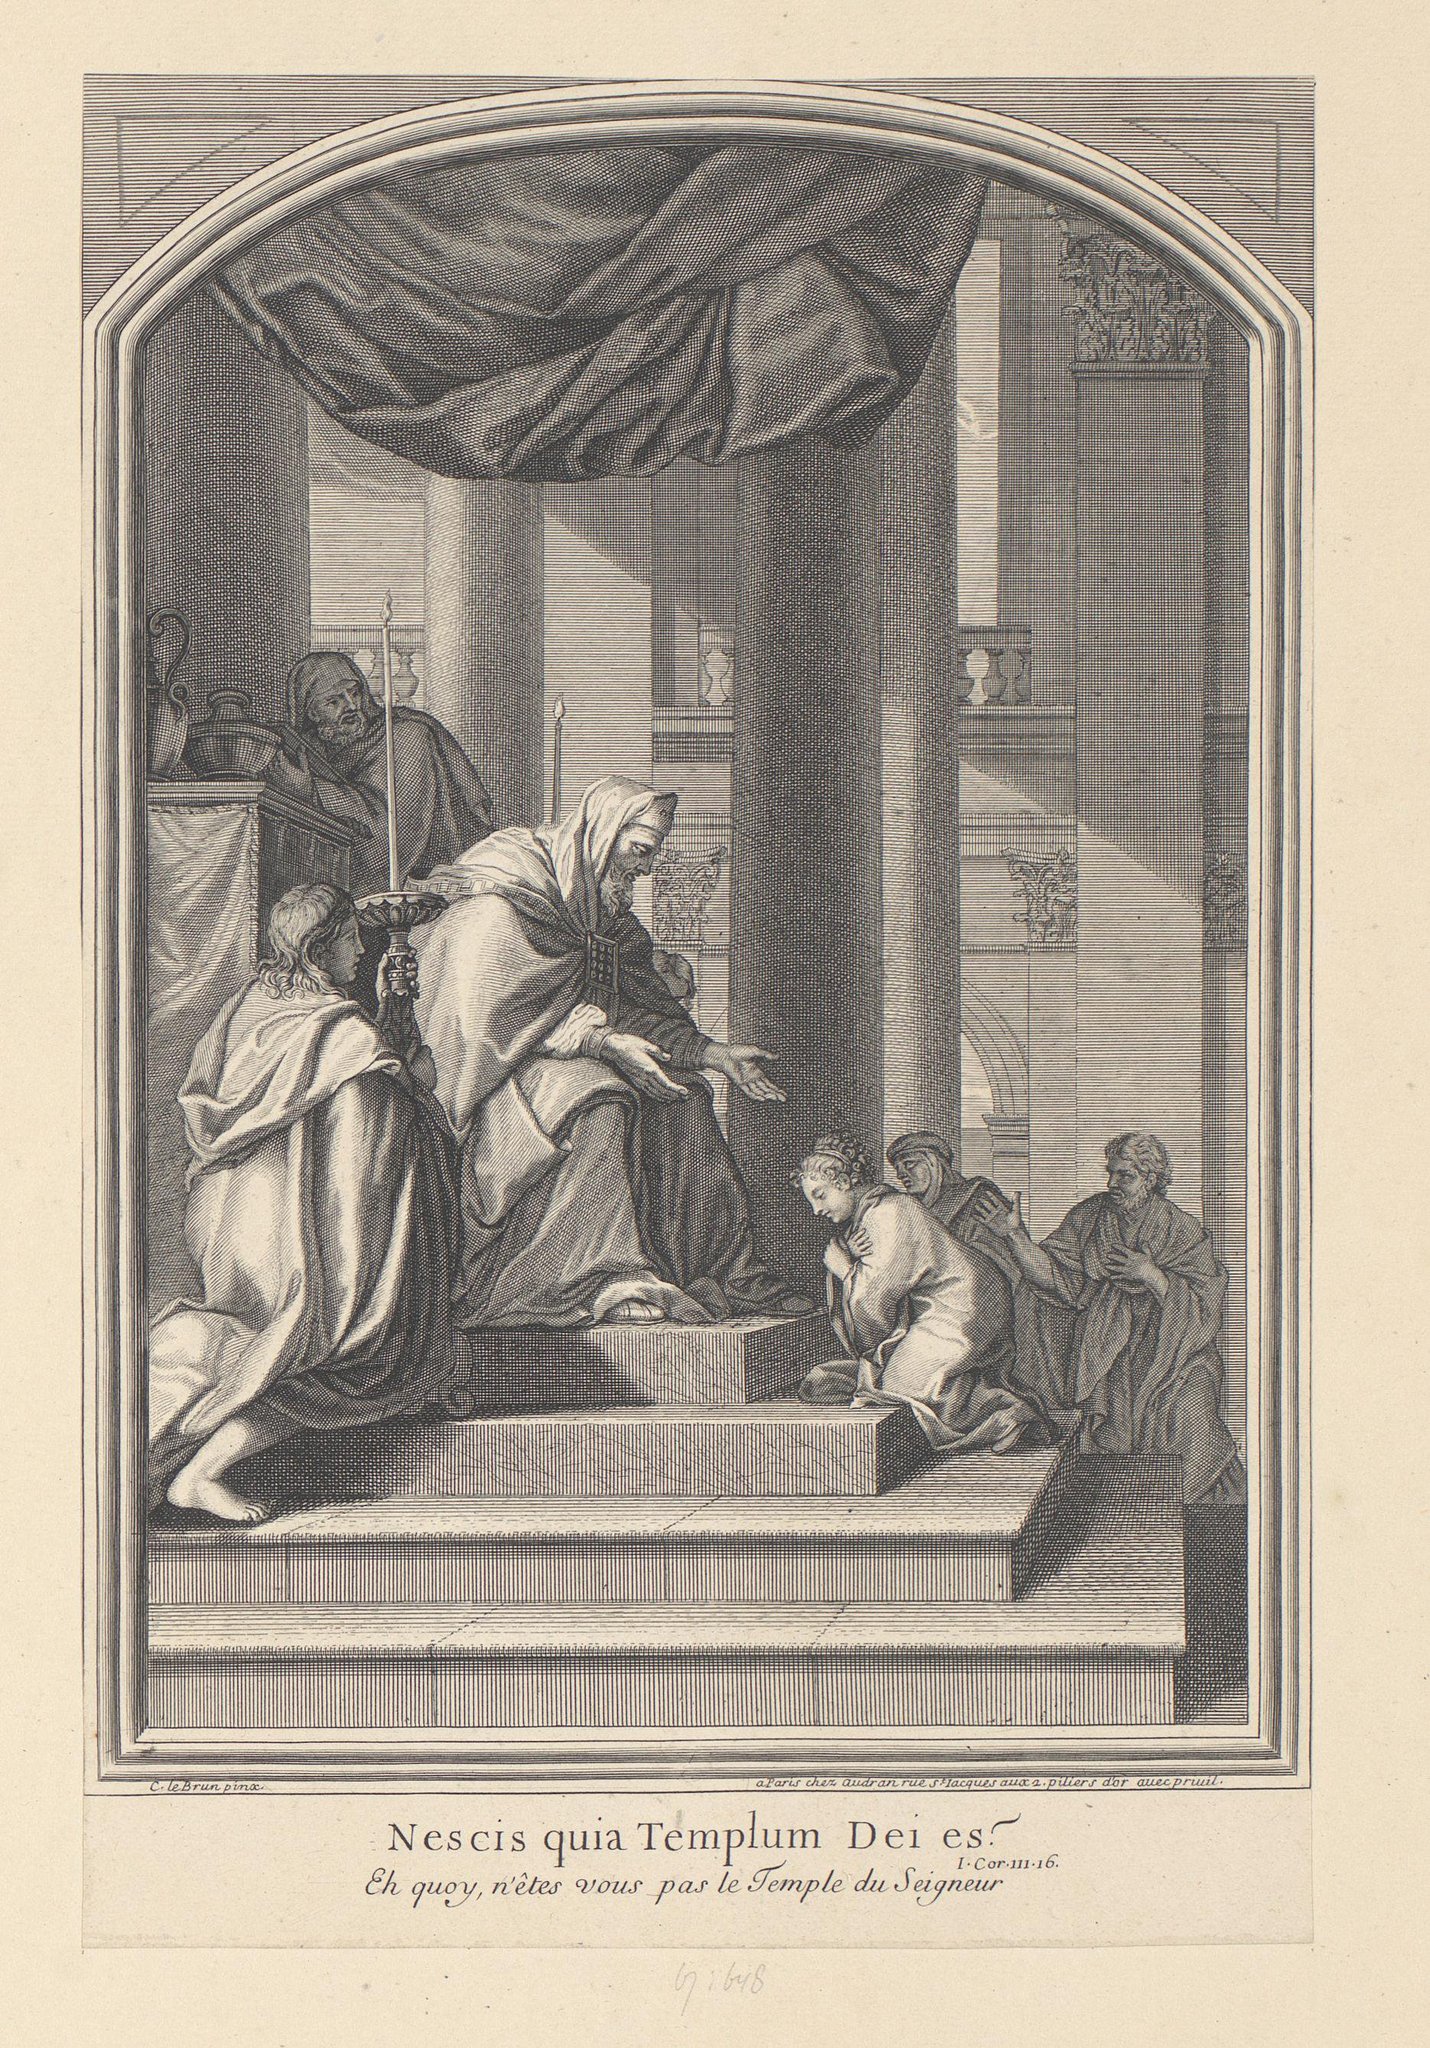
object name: album leaf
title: Nescis quia Templum Dei es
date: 1671-1721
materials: paper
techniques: engraving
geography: paris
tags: presentation of the christ-child in the temple, usually simeon (and anna) present (luke 2:22-39)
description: Deze prent maakt deel uit van een album.